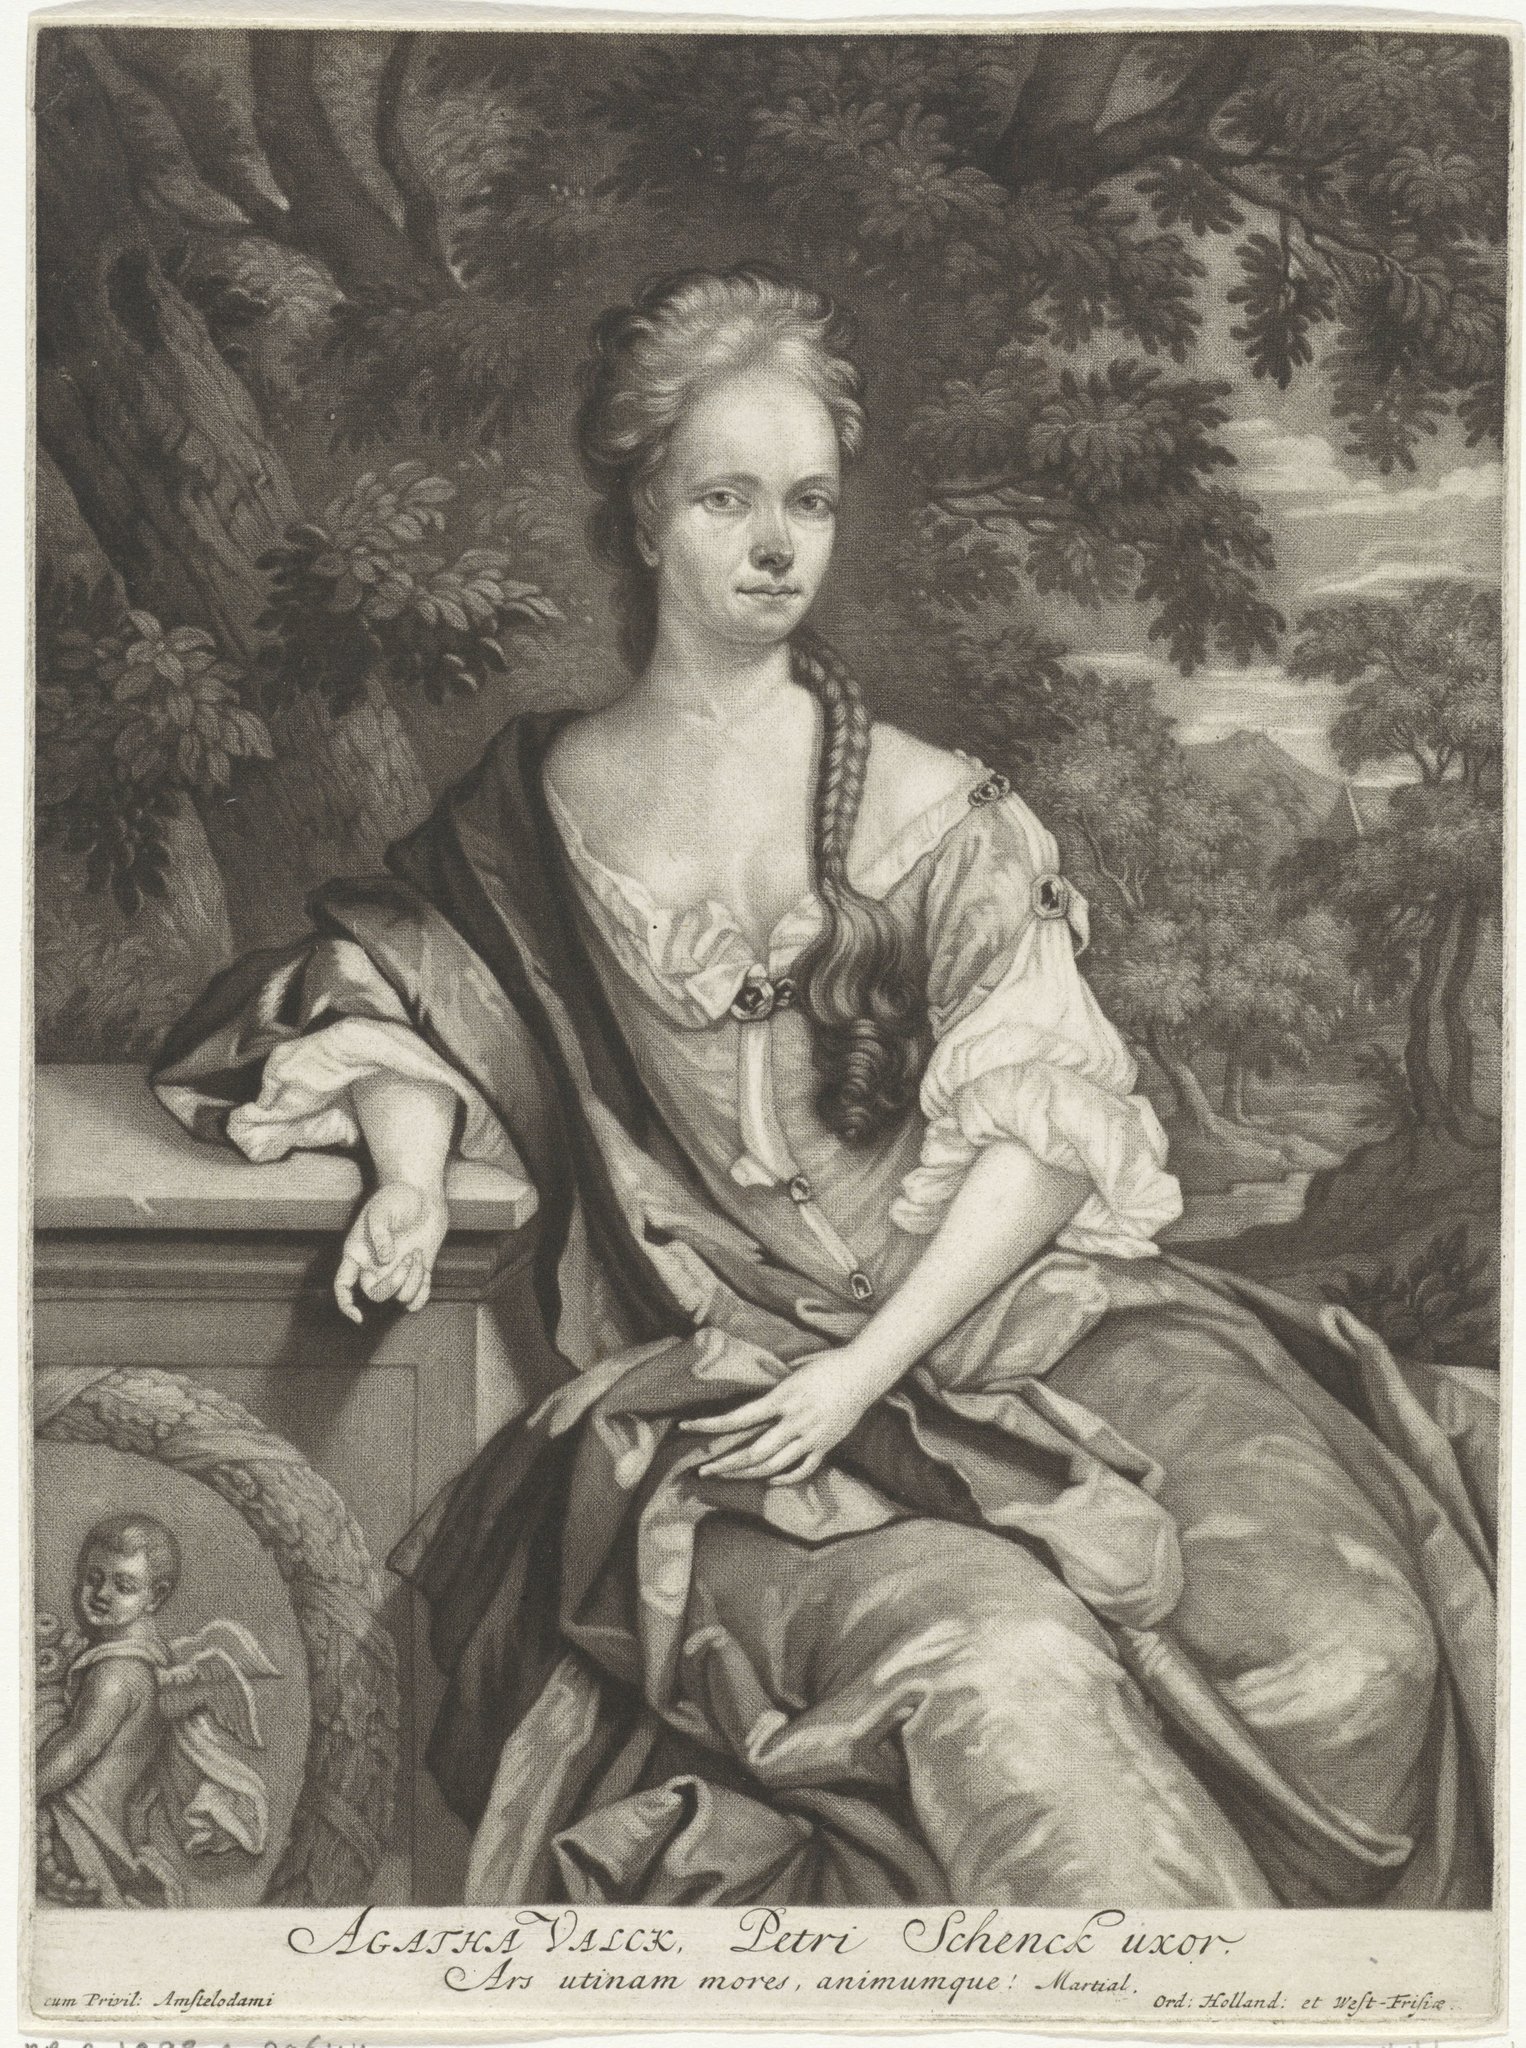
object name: print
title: Portret van Agatha Valck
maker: pieter schenk (i)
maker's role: print maker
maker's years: 1660-1711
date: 1690-1713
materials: paper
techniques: engraving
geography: amsterdam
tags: garden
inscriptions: collector's mark: Lugt 964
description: Agatha Valck, echtgenote van de prentmaker en uitgever Pieter Schenk.